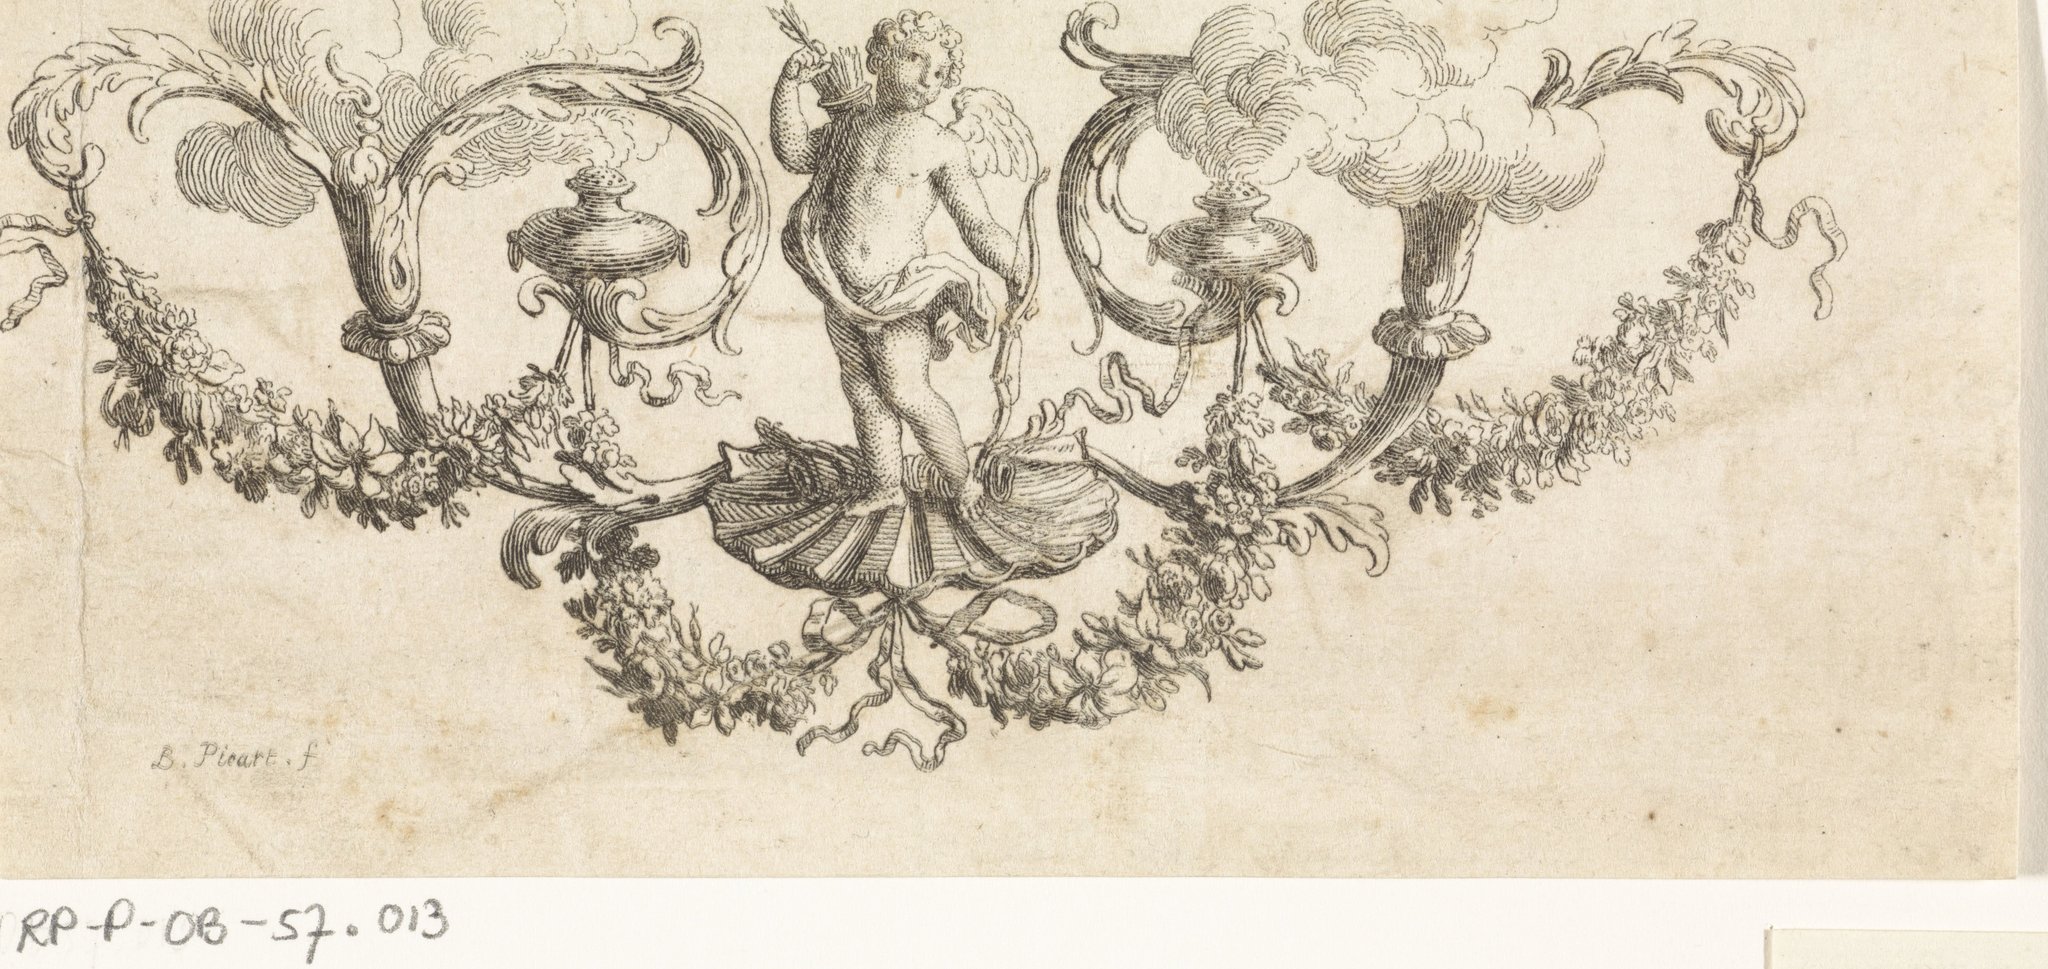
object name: book illustration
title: Amor staande op schelp omgeven door ornament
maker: bernard picart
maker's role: draughtsman, print maker, publisher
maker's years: 1673-1733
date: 1683-1733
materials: paper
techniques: etching, letterpress printing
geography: amsterdam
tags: ornaments ~ art, (story of) cupid, amor (eros)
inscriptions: collector's mark: Lugt 240